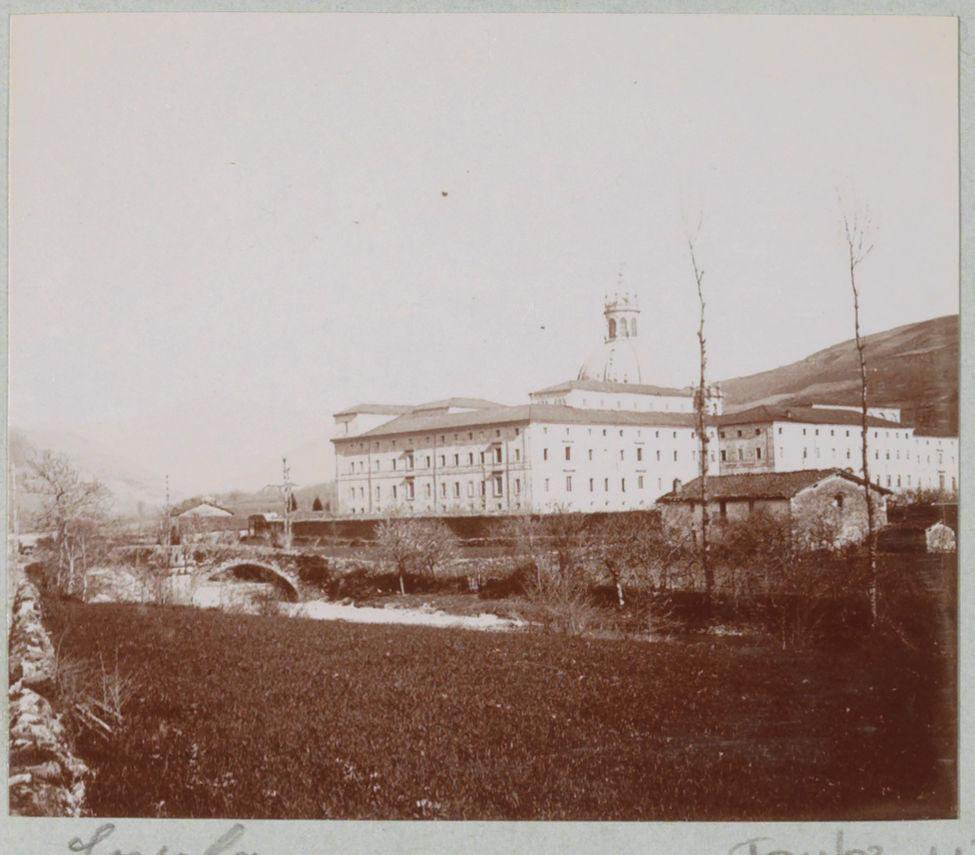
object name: photograph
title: Gezicht op het heiligdom van Loyola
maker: delizy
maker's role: manufacturer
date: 1904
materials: paper, photographic support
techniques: gelatin silver print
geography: loyola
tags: asylum, sanctuary, church (exterior)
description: Onderdeel van Fotoalbum van een Franse amateurfotograaf met opnames van uitstapjes in Frankrijk, Spanje, België, Luxemburg en Nederland, de eerste automobielen en autoraces.